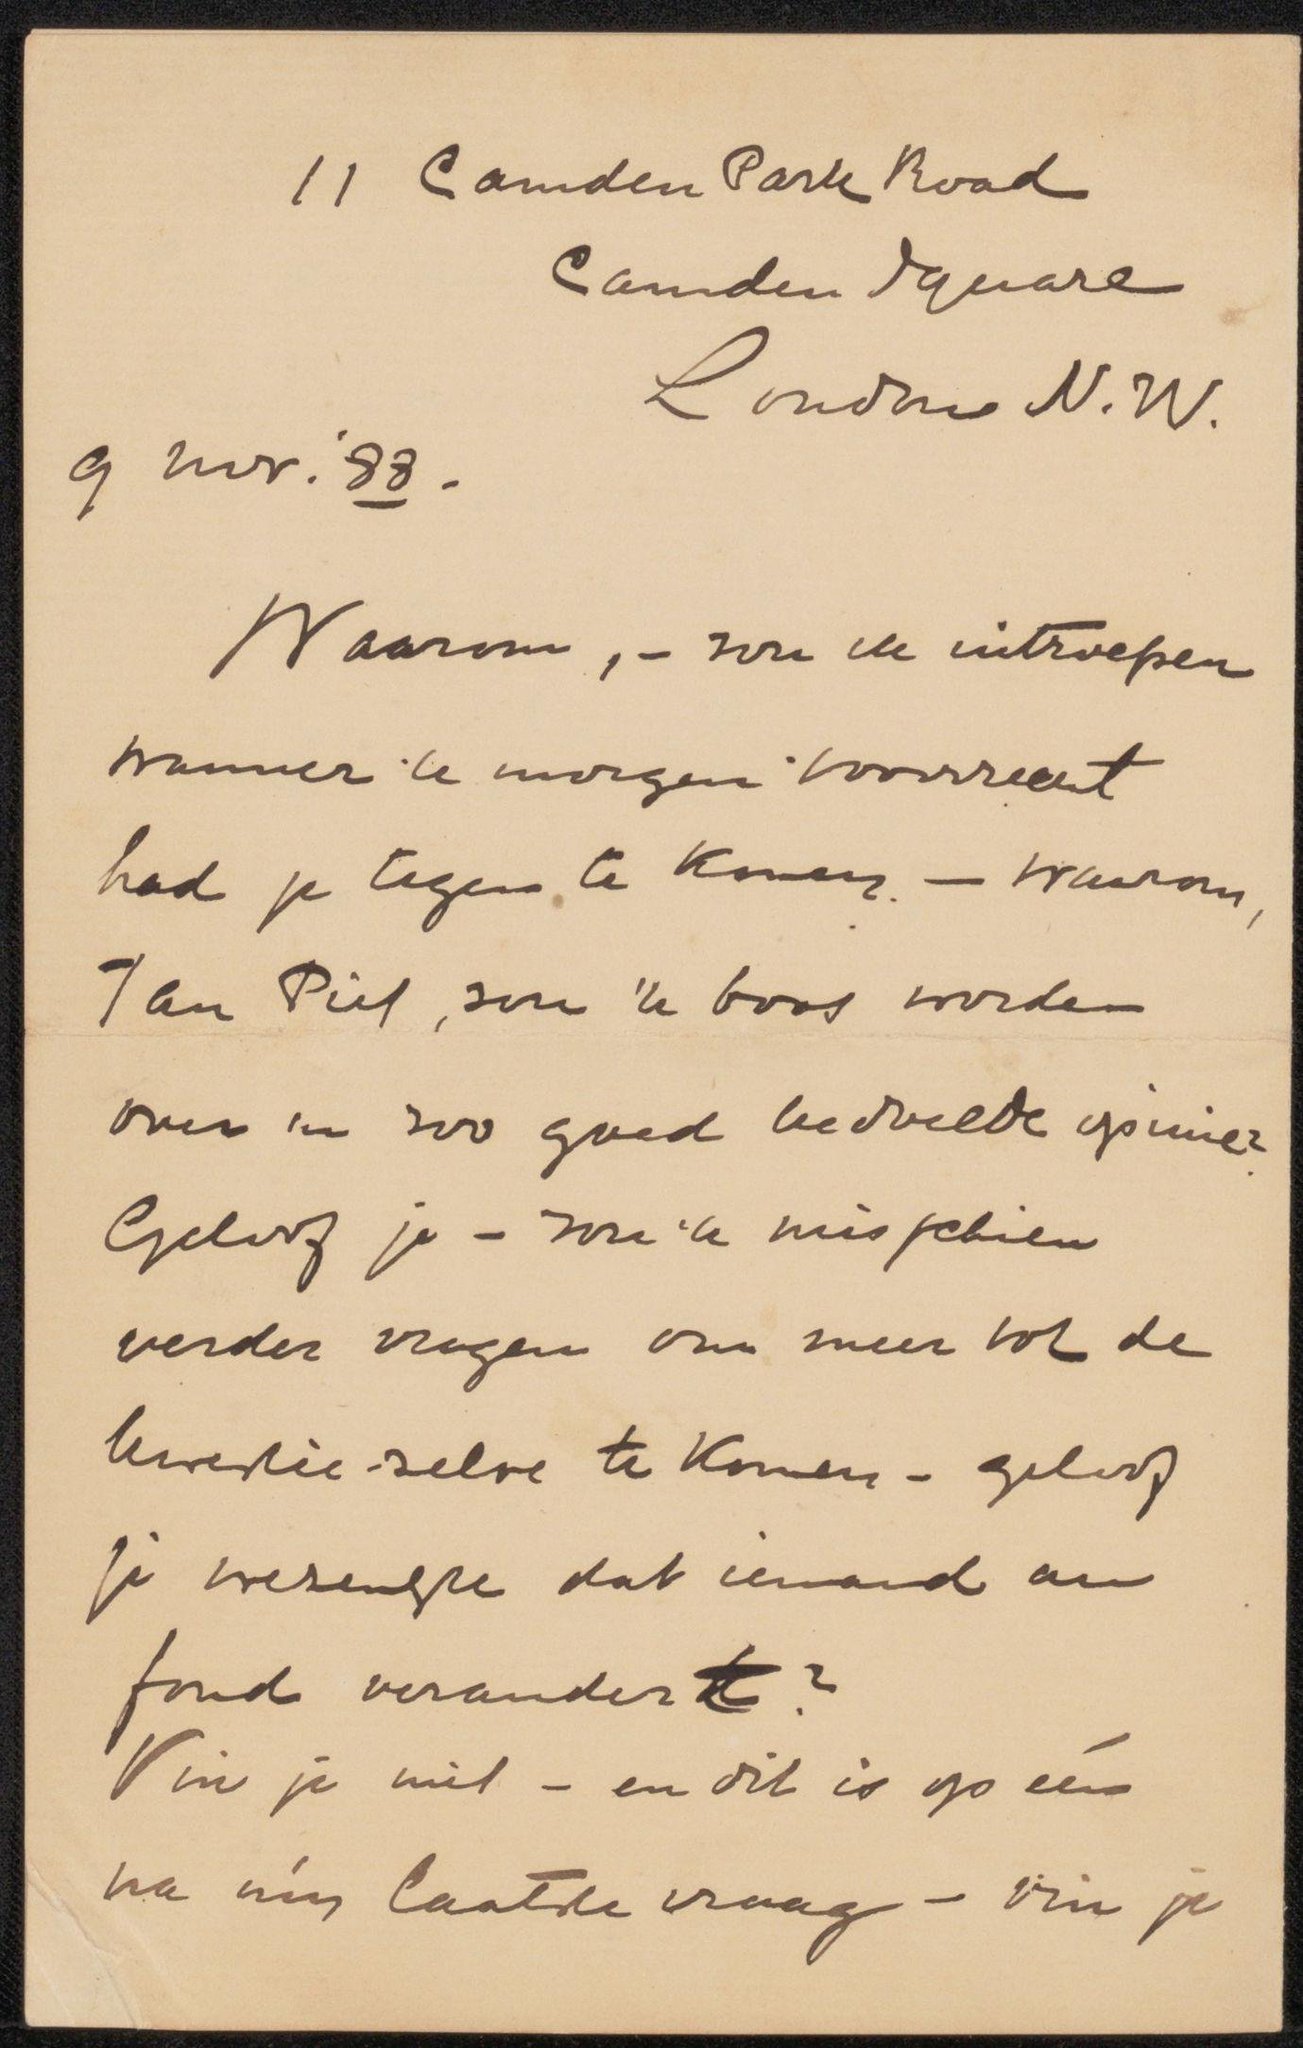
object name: letter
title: Brief aan Jan Veth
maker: willem witsen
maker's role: draughtsman, painter, print maker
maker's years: 1860-1923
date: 1888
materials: ink, paper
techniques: pen, writing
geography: london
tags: dordrecht, designer, jan veth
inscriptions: collector's mark: ‘RPK’